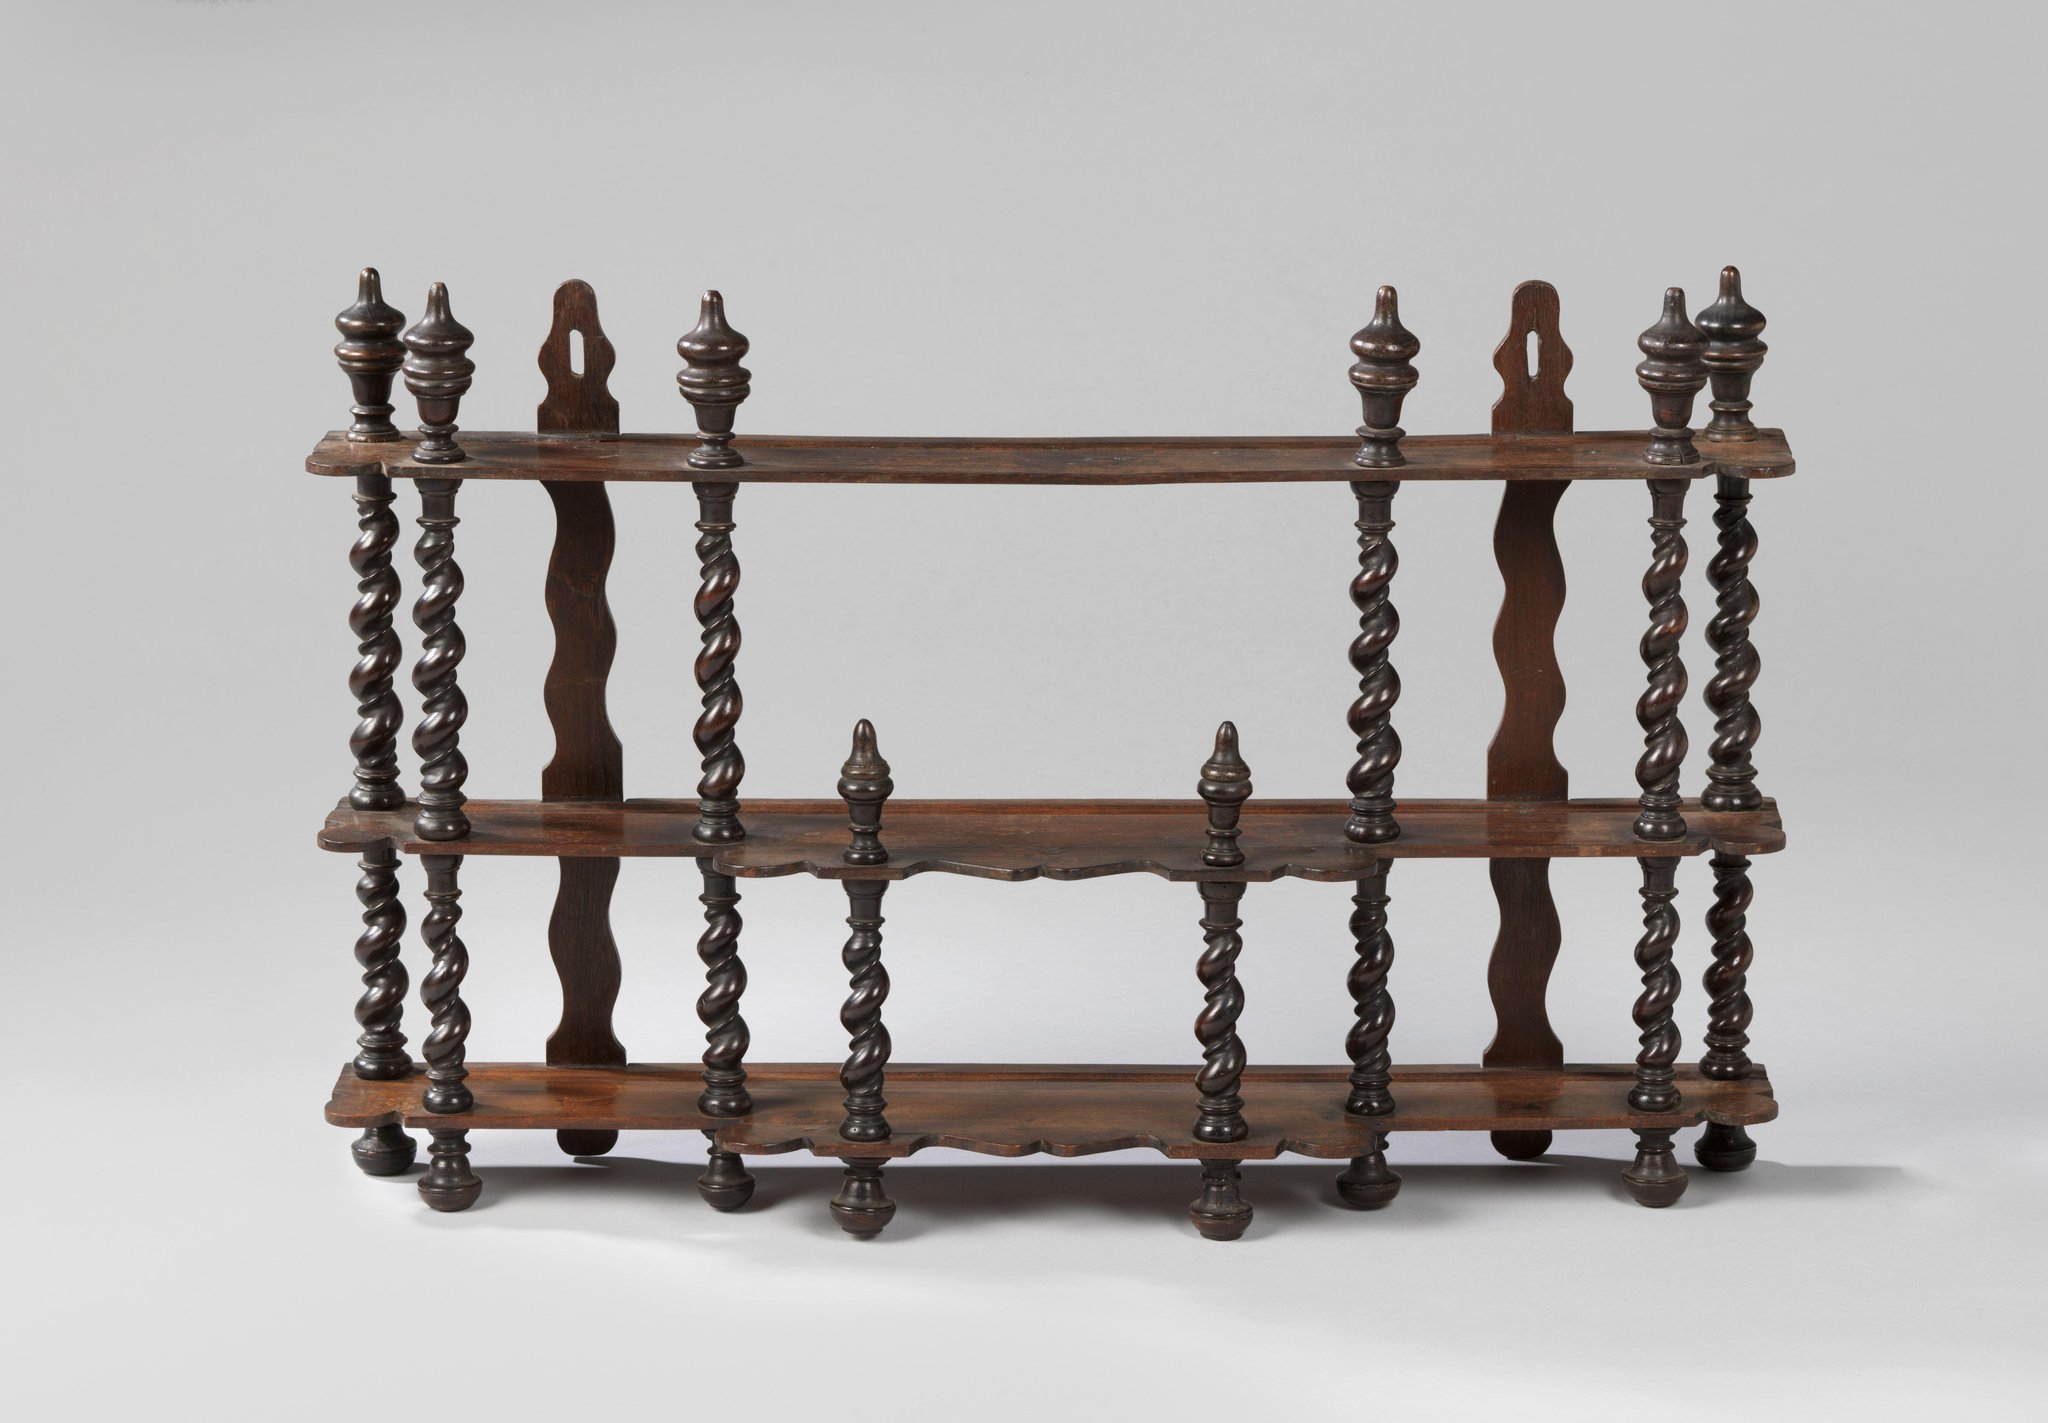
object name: case furniture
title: Wandrek of étagère van notenhout met drie planken, verbonden door getordeerde stijlen.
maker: Anonymous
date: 1685-1700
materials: wood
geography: northern netherlands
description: Wandrek of étagère van notenhout met drie horizontale planken door twee maal drie getordeerde stijlen verbonden. De twee onderste planken zijn in het midden van uitgeschulpte verbredingen voorzien, die door korte getordeerde stijlen zijn verbonden. De planken zijn op de korte hoeken uitgeschulpt; de stijlen hebben onder en boven een gedraaide knop. Het rek wordt opgehangen aan twee platte geschulpte stijlen met ogen.